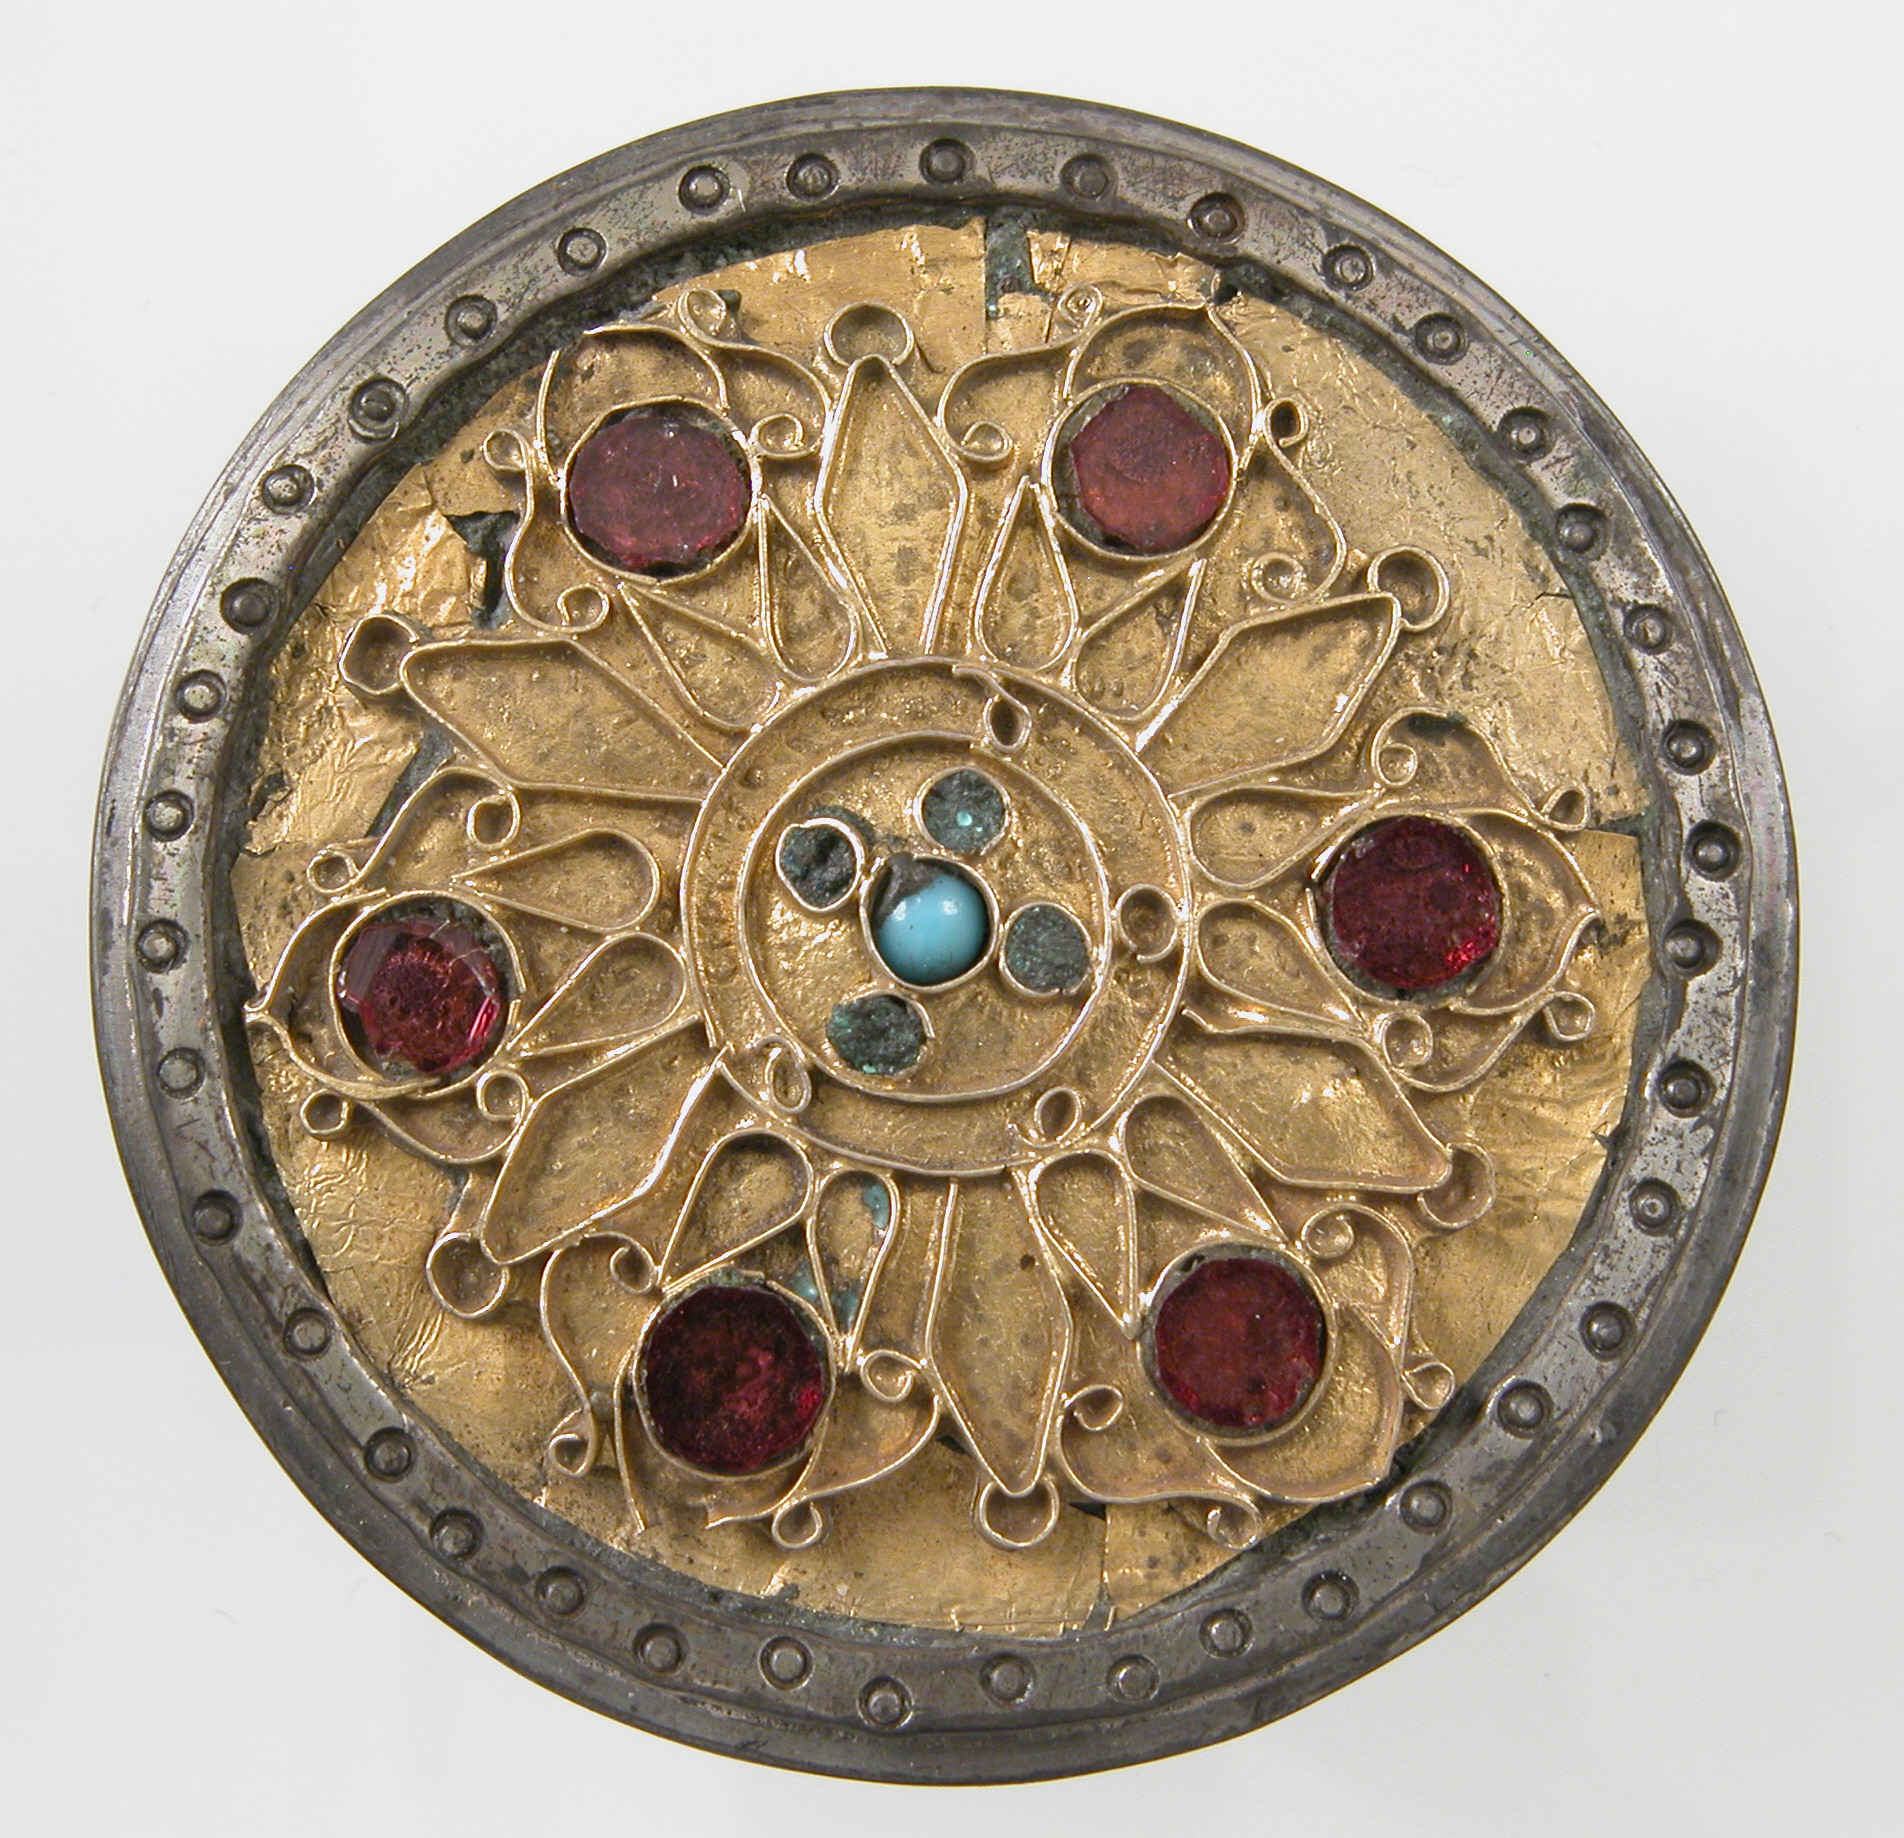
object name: brooch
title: Disk Brooch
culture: frankish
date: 701-800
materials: garnet, glass, gold, silver